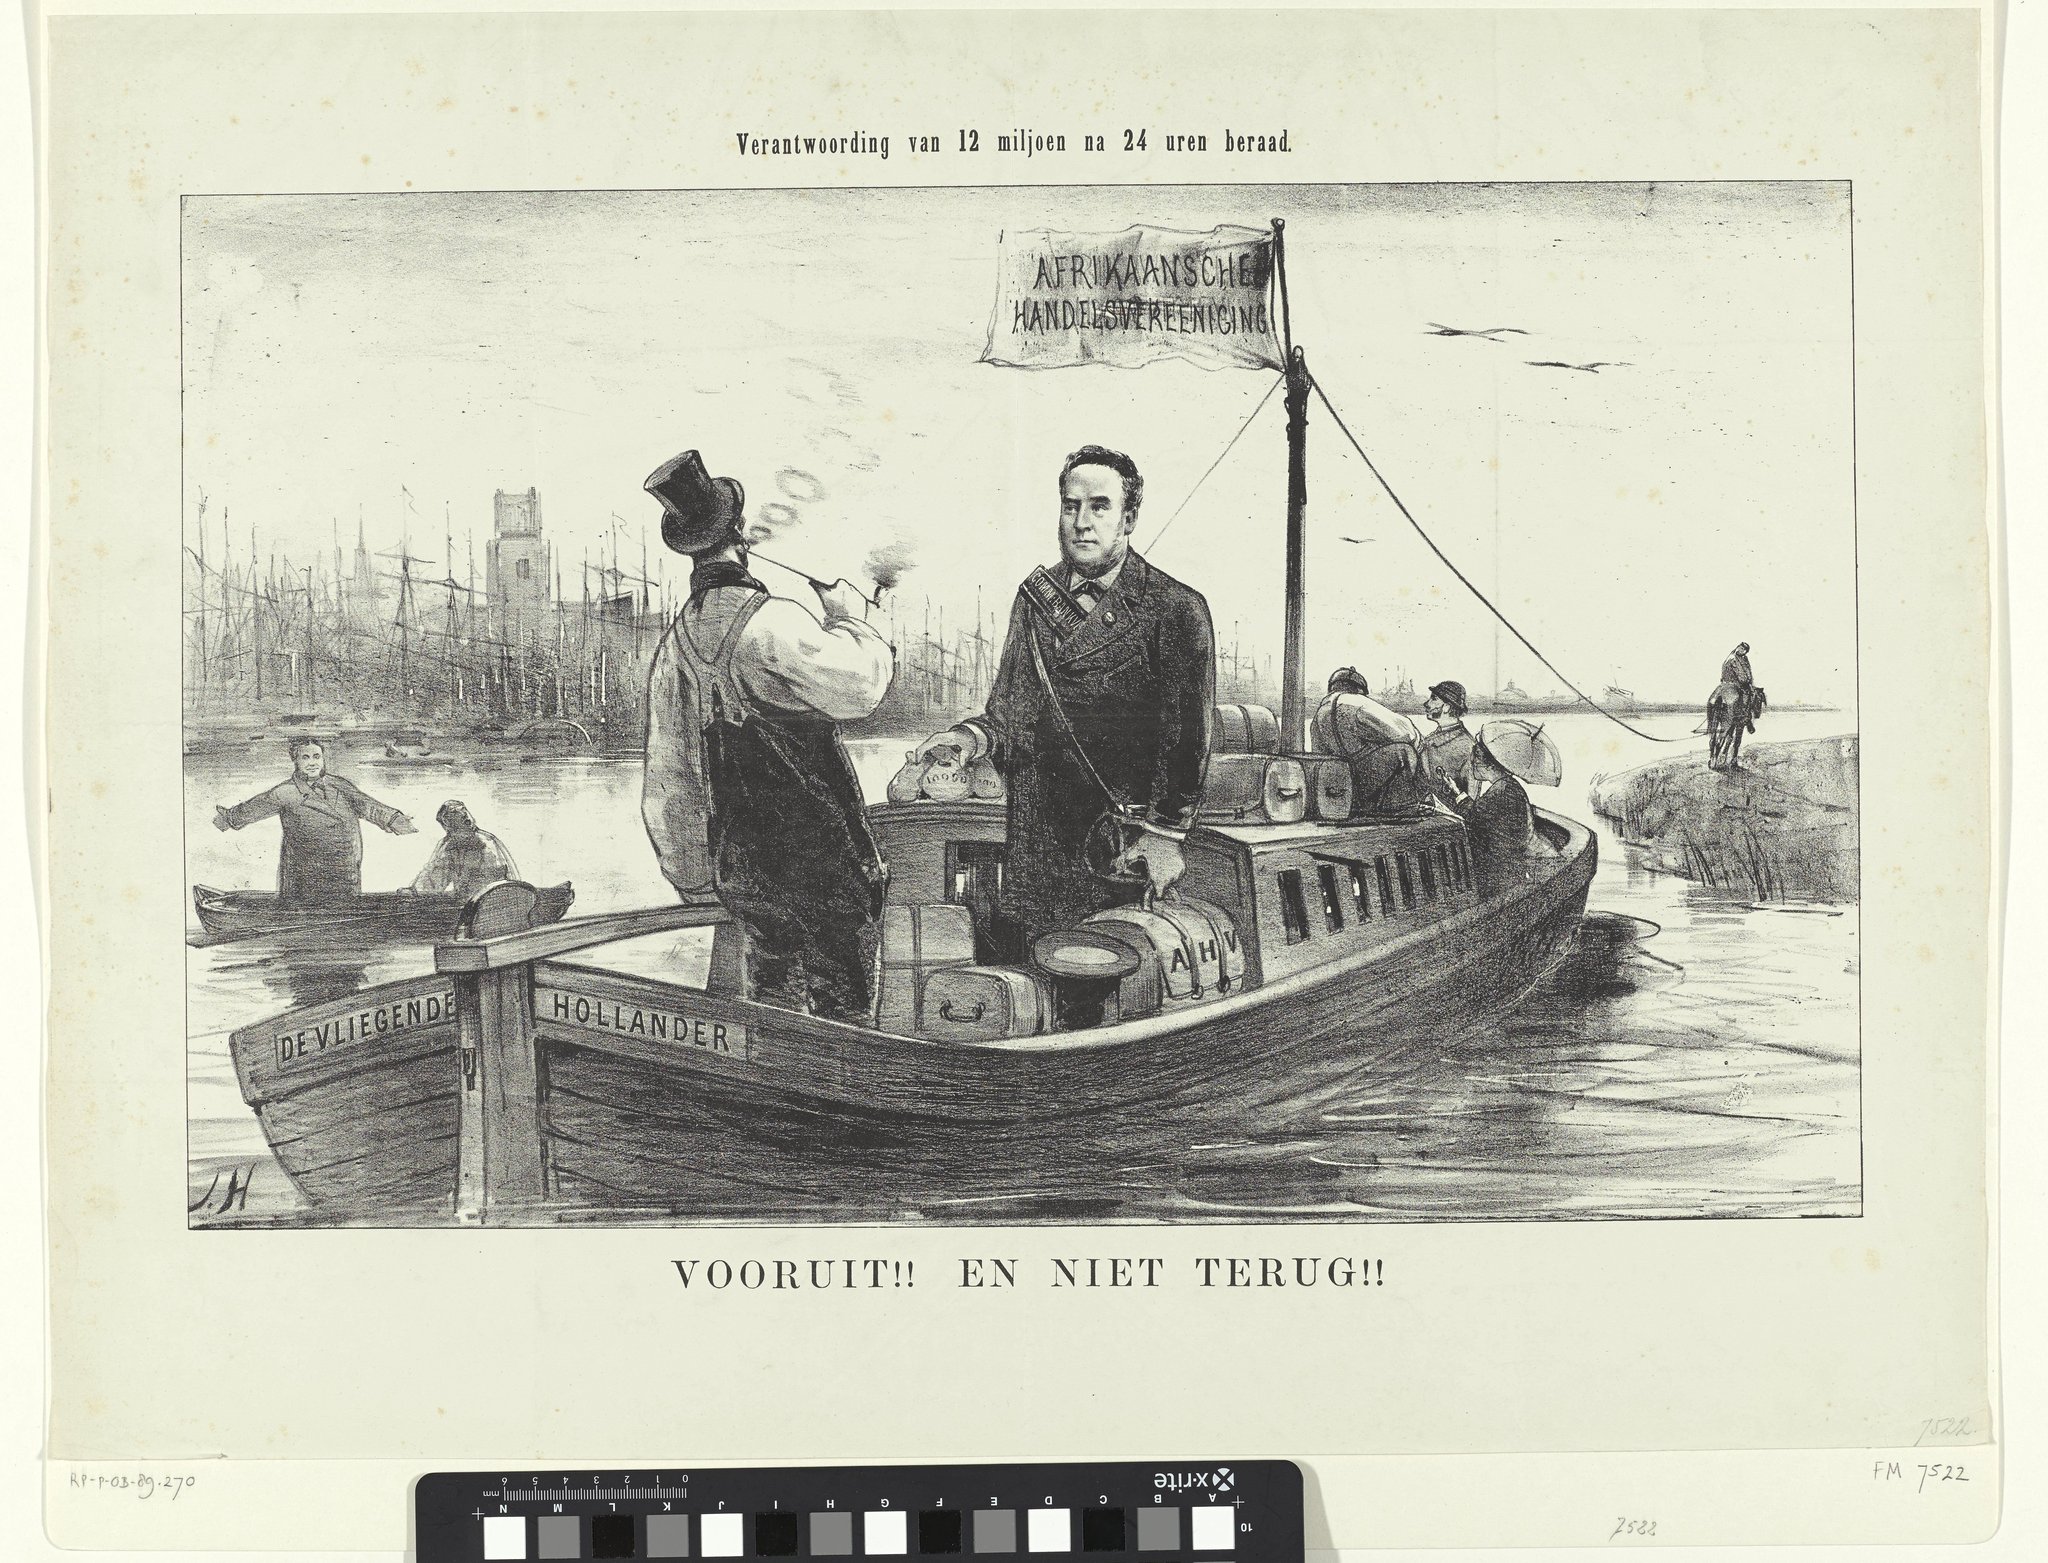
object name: cartoon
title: Vooruit!! en niet terug!!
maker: monogrammist jh (nederland)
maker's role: print maker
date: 1879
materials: paper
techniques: lithograph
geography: netherlands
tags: rotterdam, new york (city), ships (in general) (+ propulsion of vehicle, ship, etc. by animals)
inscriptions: collector's mark: Lugt 2228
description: Spotprent op de vlucht van Lodewijk Pincoffs naar de Verenigde Staten, na het aan het licht komen van de fraude door hem gepleegd me zijn Afrikaansche Handelsvereeniging te Rotterdam, 15 mei 1879. Pincoffs staande in een trekschuit genaamd 'De Vliegende Hollander' met koffers en geldzakken. Links op het water in een klein bootje zijn mededirecteur A. Kerdijk.